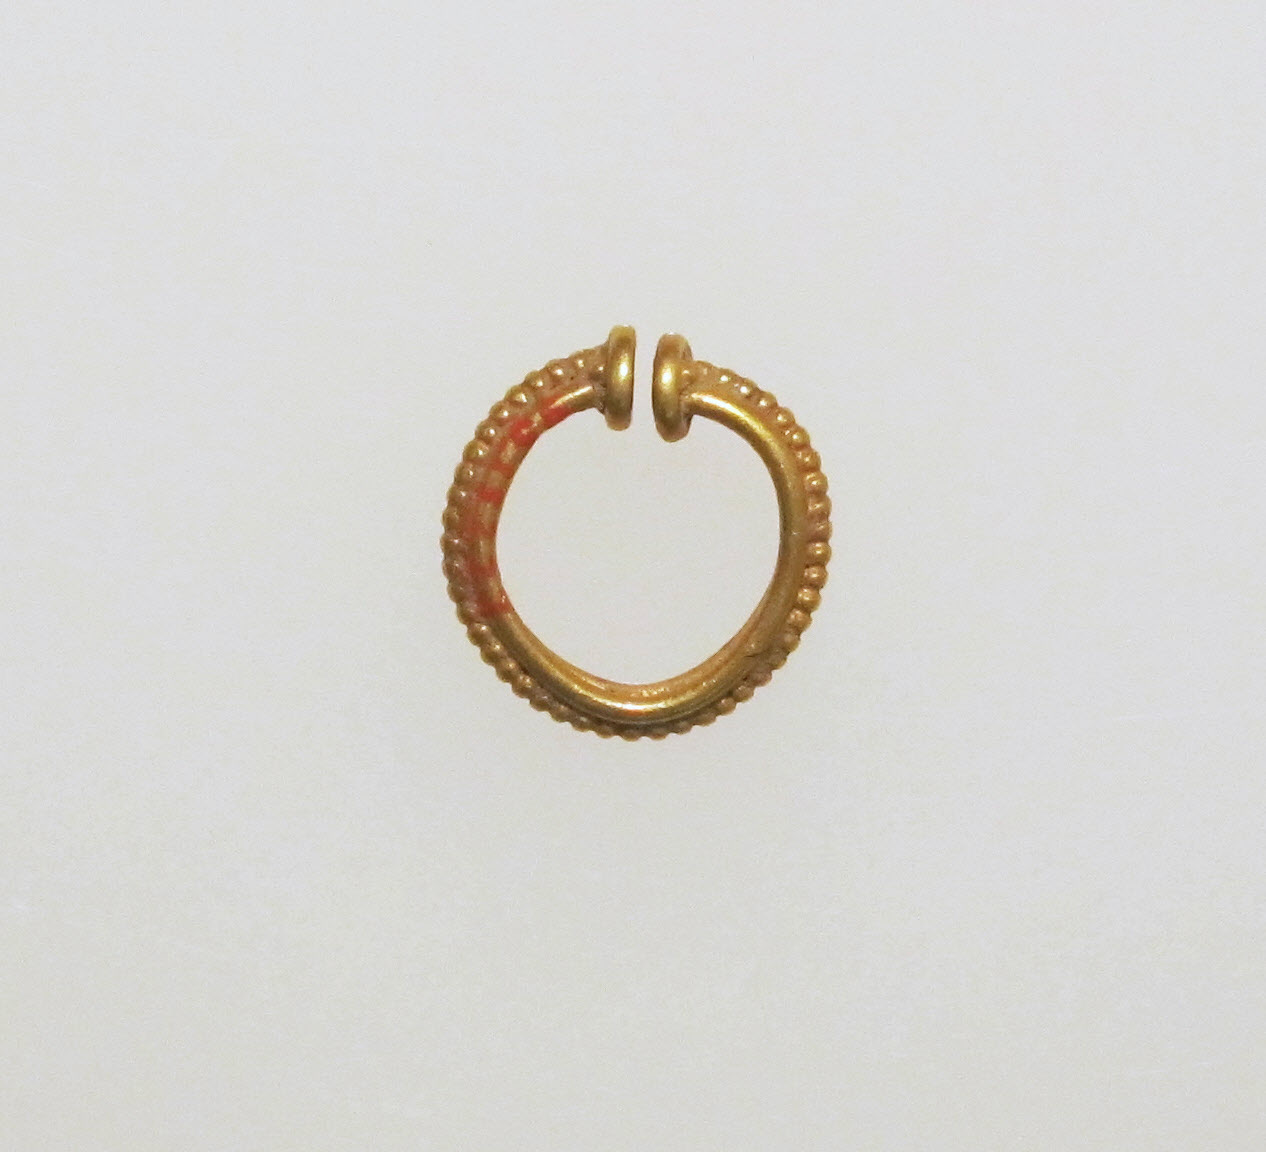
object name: earring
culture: etruscan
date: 900-100 BCE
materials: gold